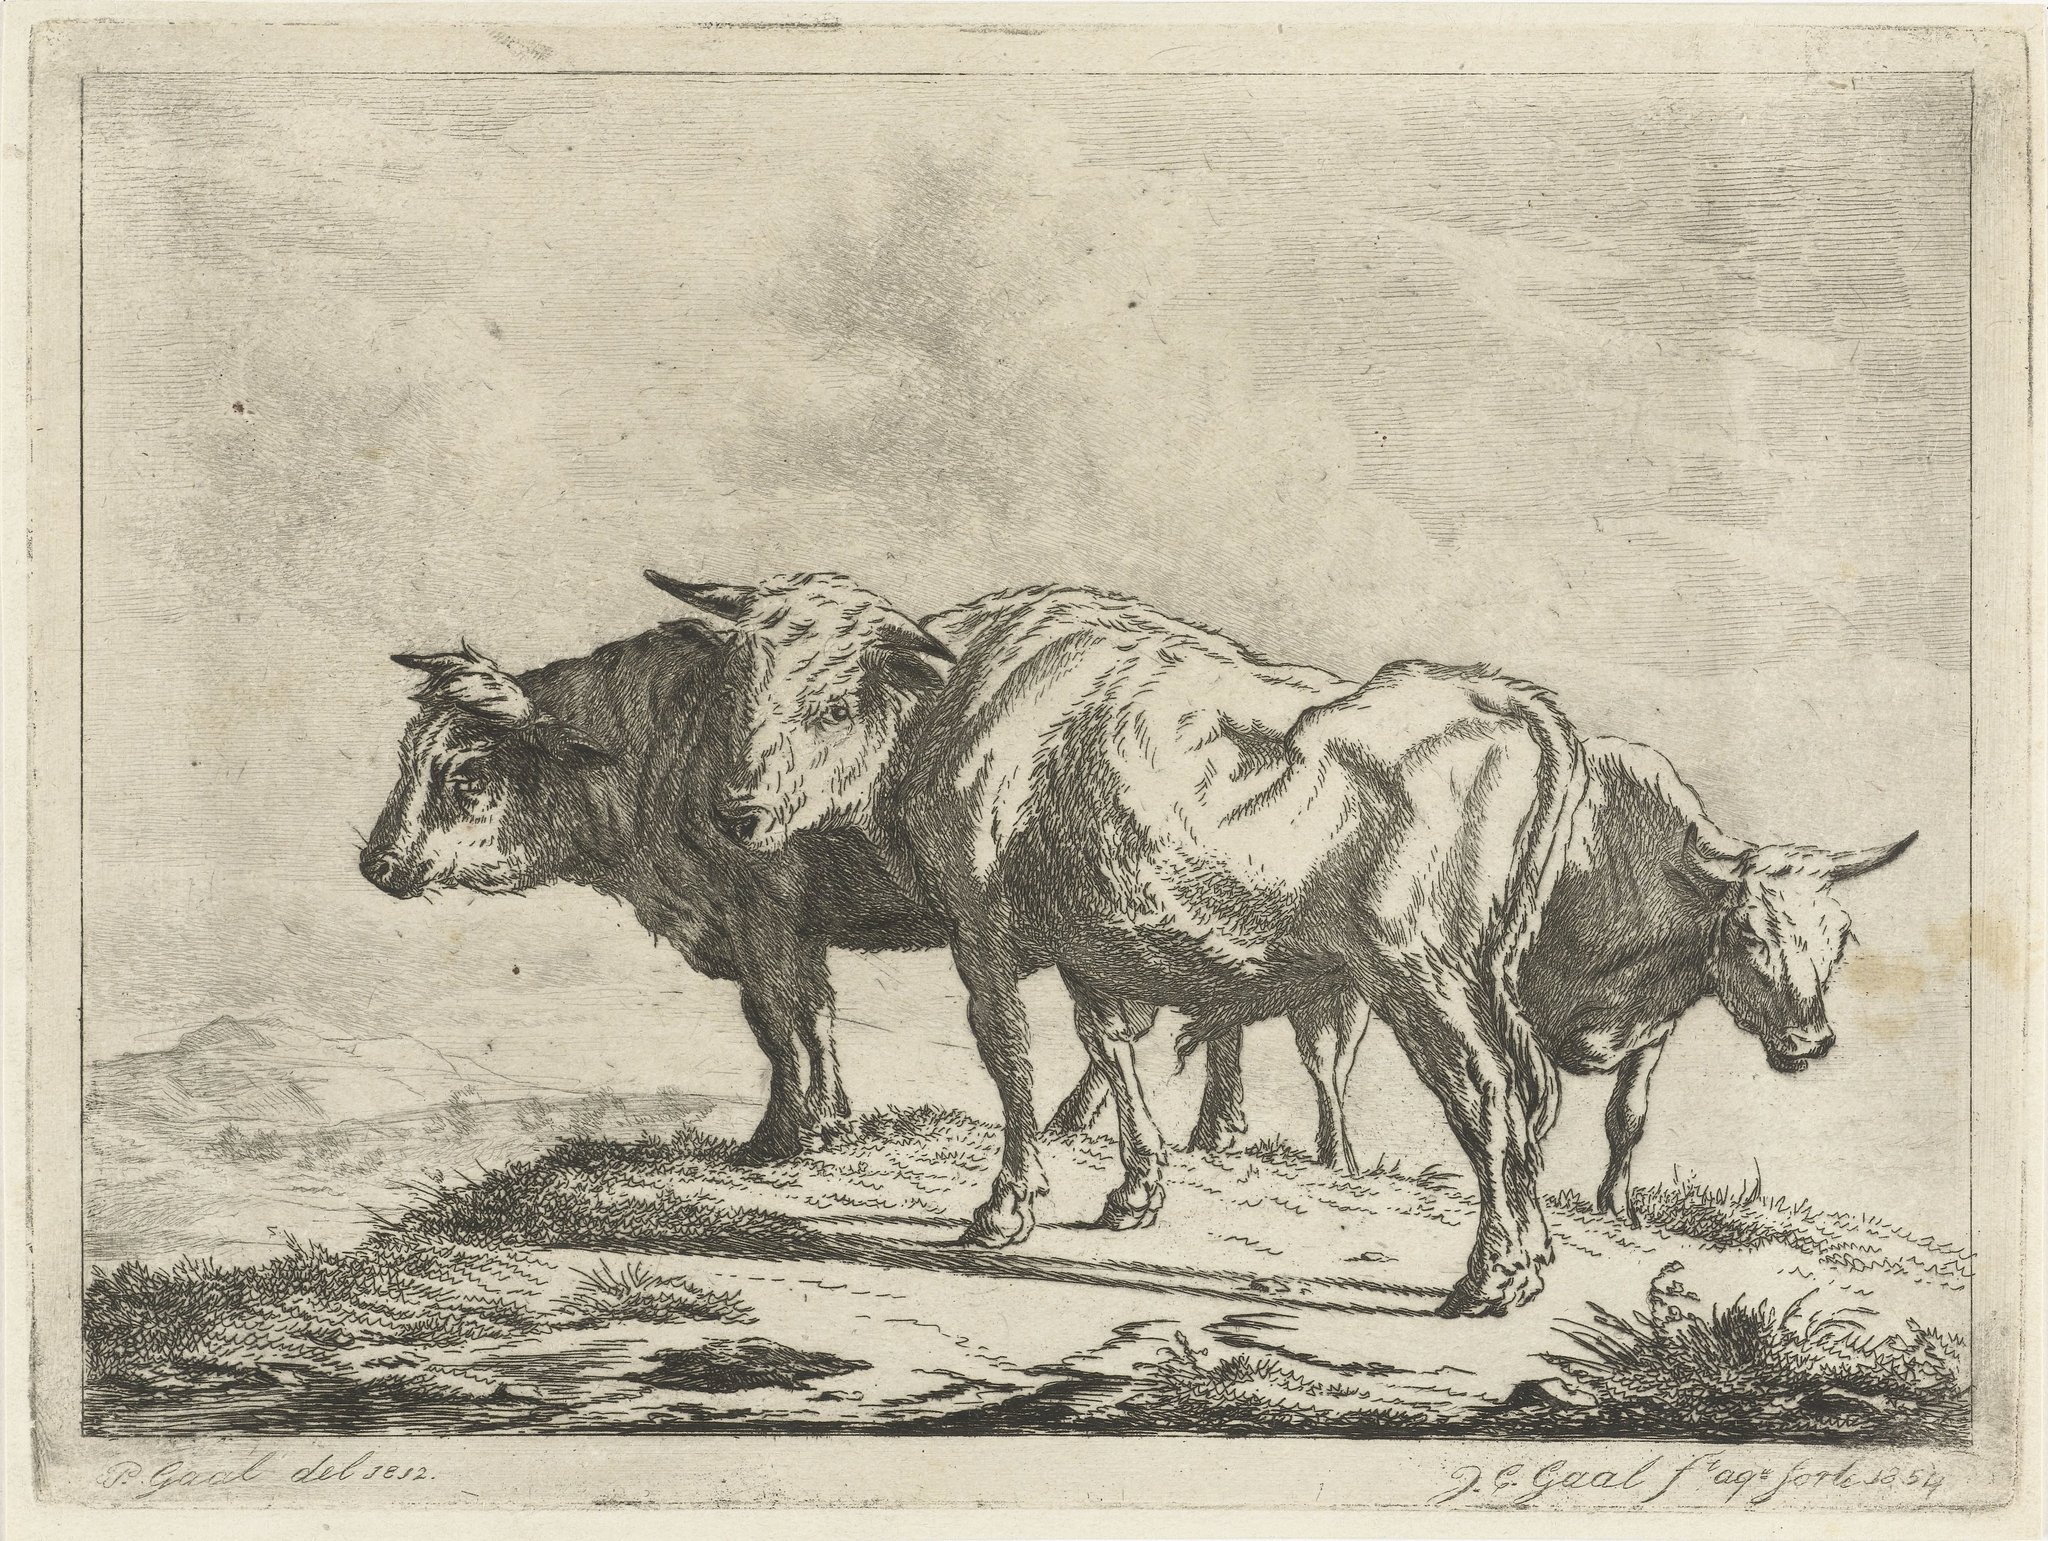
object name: print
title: Drie ossen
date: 1854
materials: paper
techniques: etching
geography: netherlands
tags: bull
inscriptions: collector's mark: Lugt 2228